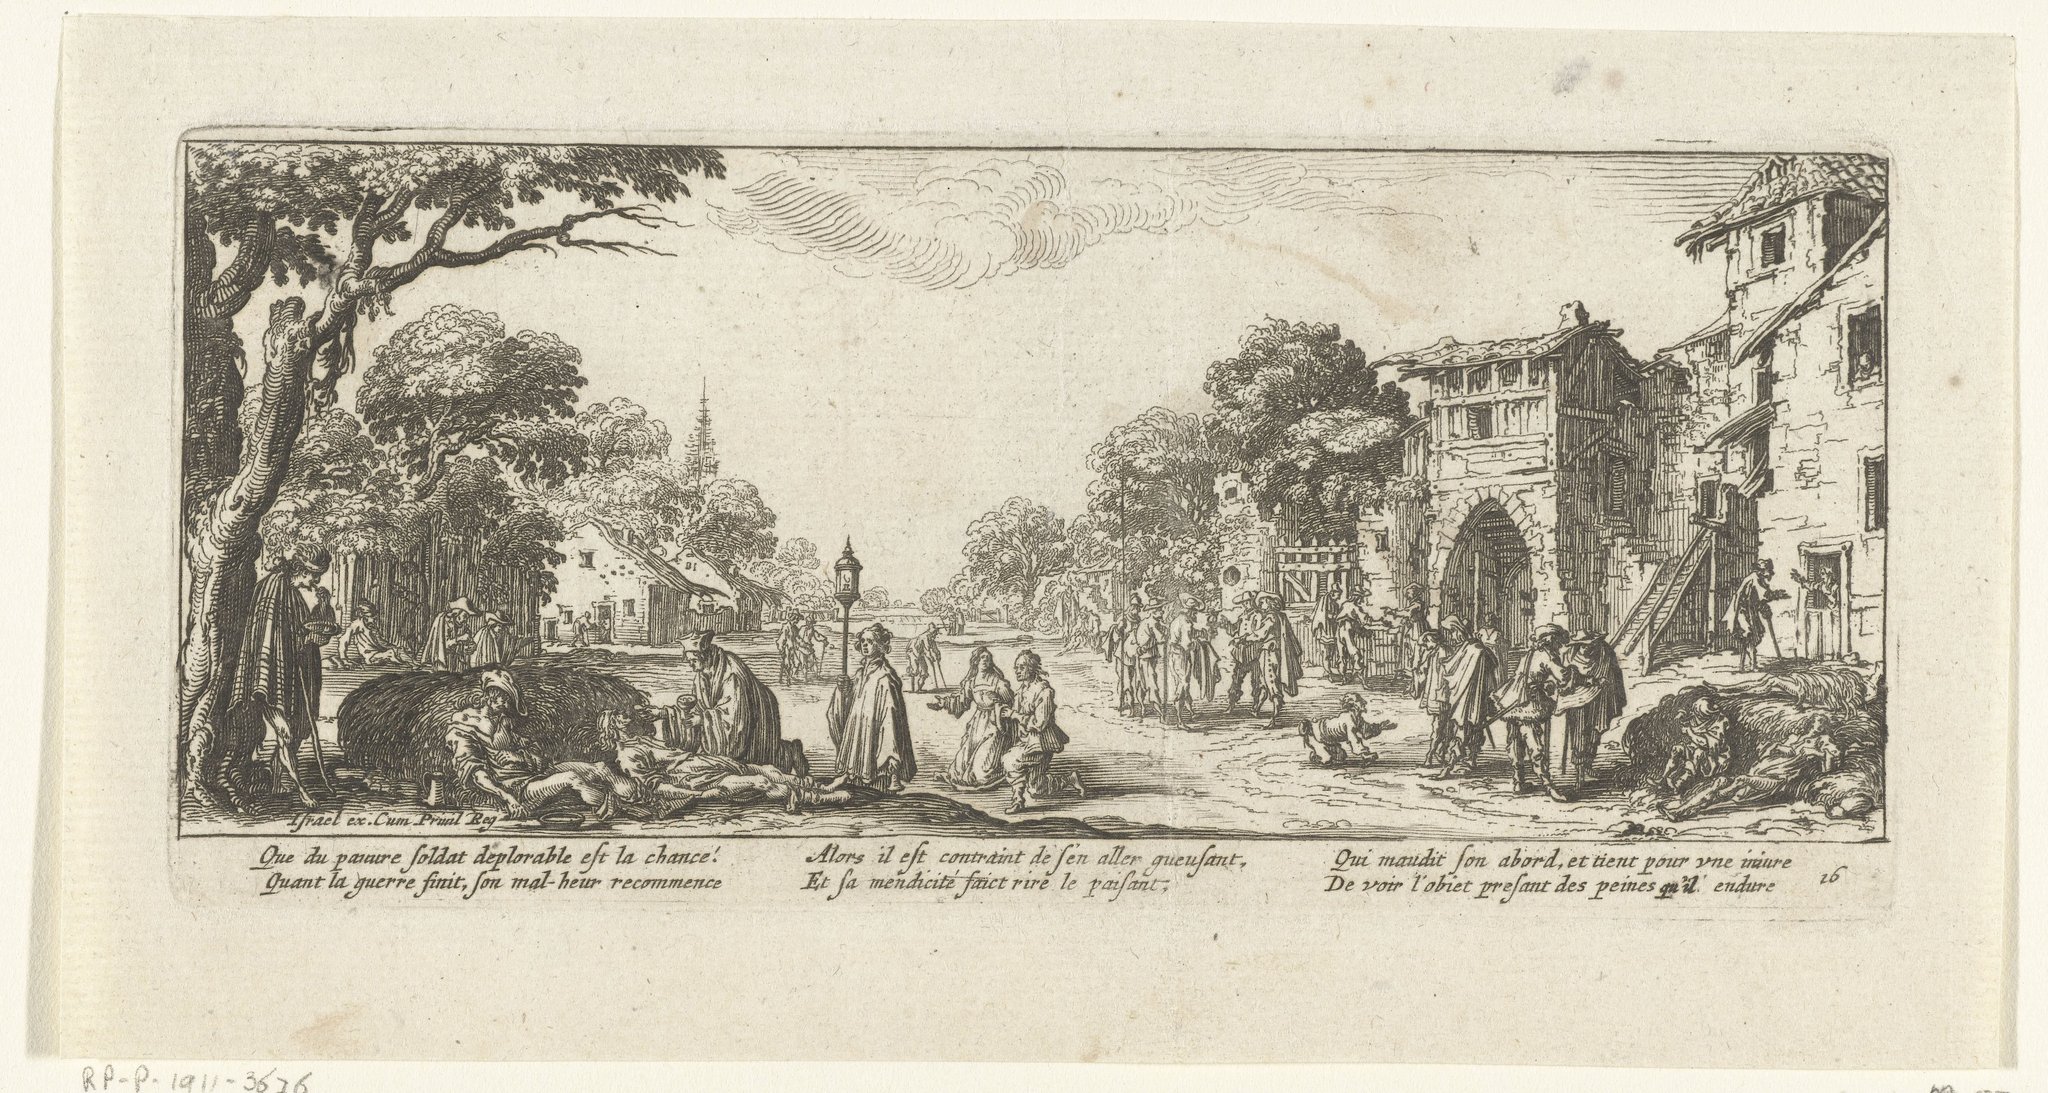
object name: print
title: Bedelaars en stervenden langs de weg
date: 1677-1690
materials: paper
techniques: etching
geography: netherlands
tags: deathbed, disabled soldier, beggar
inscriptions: collector's mark: Lugt 2228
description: Op een weg omzoomd door huizen lopen en strompelen verarmde soldaten en oorlogsslachtoffers. Zij bedelen bij de dorpsbewoners om een aalmoes. Op de voorgrond links en rechts liggen enkelen uitgeput tegen balen hooi. Links staat een geestelijke een stervende bij. Onder de voorstelling een zesregelig Frans vers. Deze prent is onderdeel van een serie van 17 (18 incl. titelprent) prenten met voorstellingen van diverse soorten ellende die oorlogvoering met zich meebrengt.